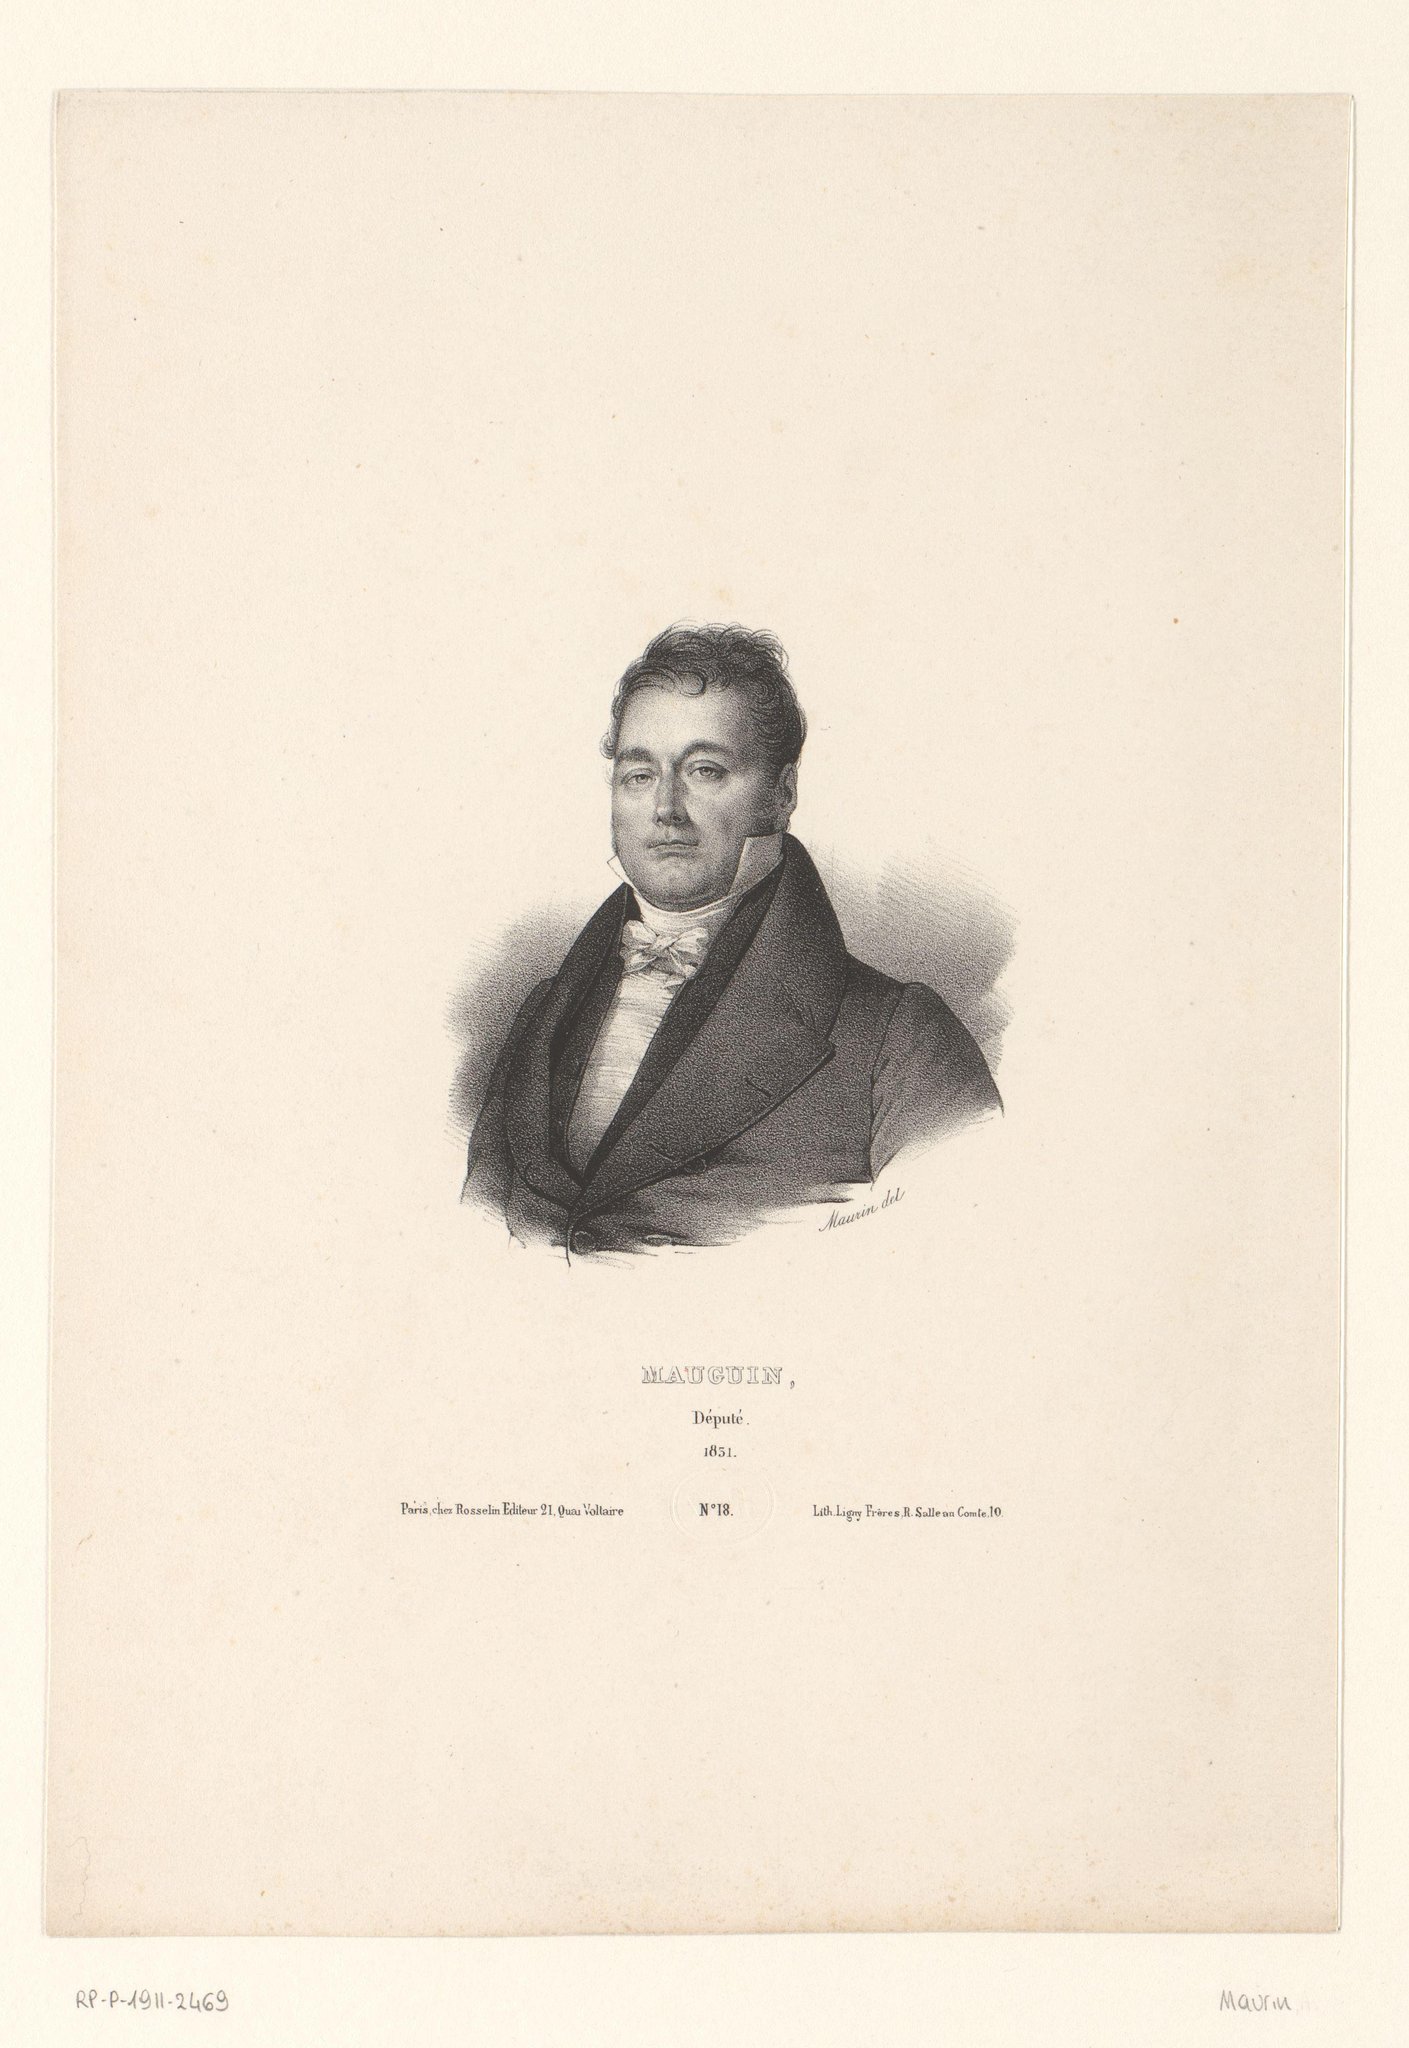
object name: print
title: Mauguin, député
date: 1831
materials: paper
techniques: lithograph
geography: paris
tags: politician, historical persons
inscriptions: collector's mark: Lugt 2228, check stamp: Lugt 3693